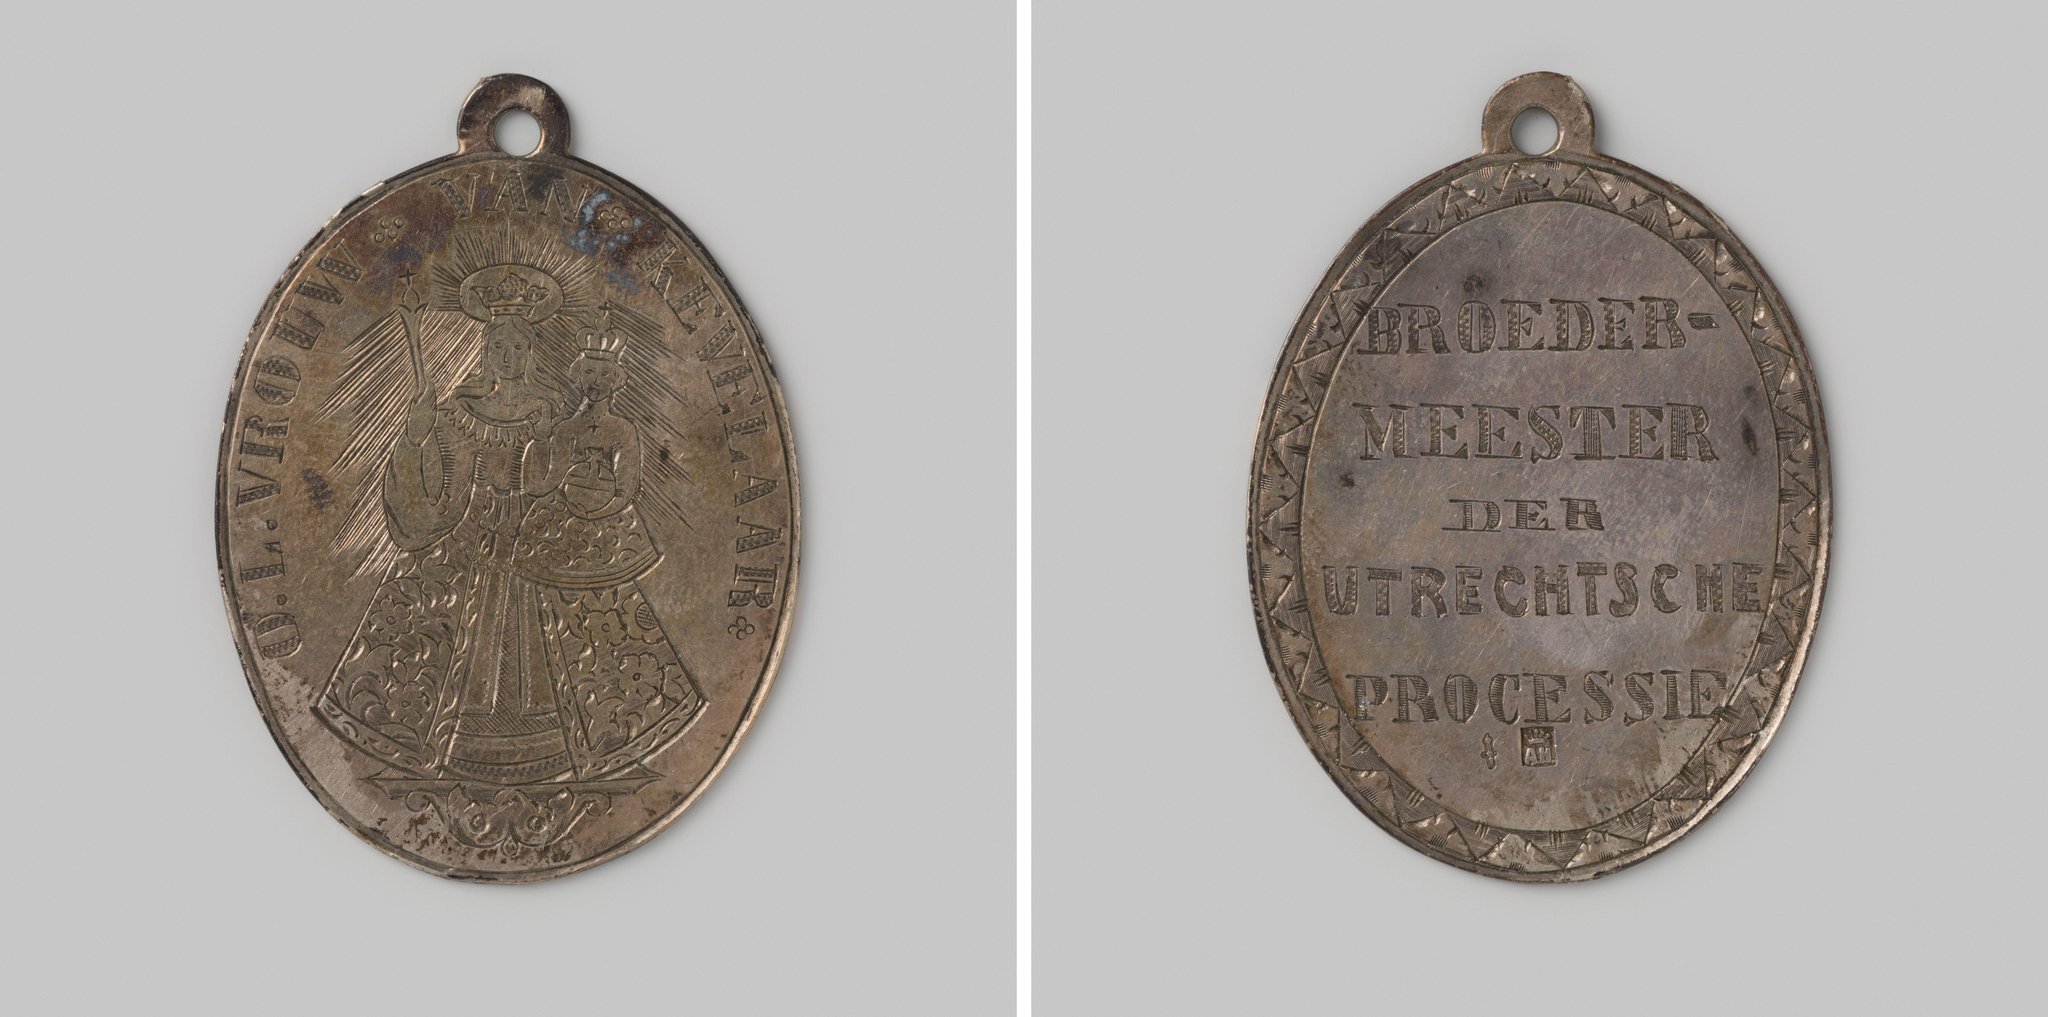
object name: history medal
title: Draagteken van de Broedermeester van de Utrechtsche Processie naar Kevelaar (1890)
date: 1890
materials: silver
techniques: engraving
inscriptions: hallmark: ‘zwaardje’, circumscription: ‘O. L. VROUW (rozet) VAN (rozet) KEVELAAR (rozet)’, inscription: ‘BROEDER- / MEESTER / DER / UTRECHTSCHE / PROCESSIE’, maker's mark: ‘A.H. onder kroon’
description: Ovalen penning met draagoog, tweezijdig gegraveerd, op de voorzijde Onze Lieve Vrouwe van Kevelaar met scepter en kind, met omschrift, op de keerzijde vijf regels tekst binnen een versierde rand.